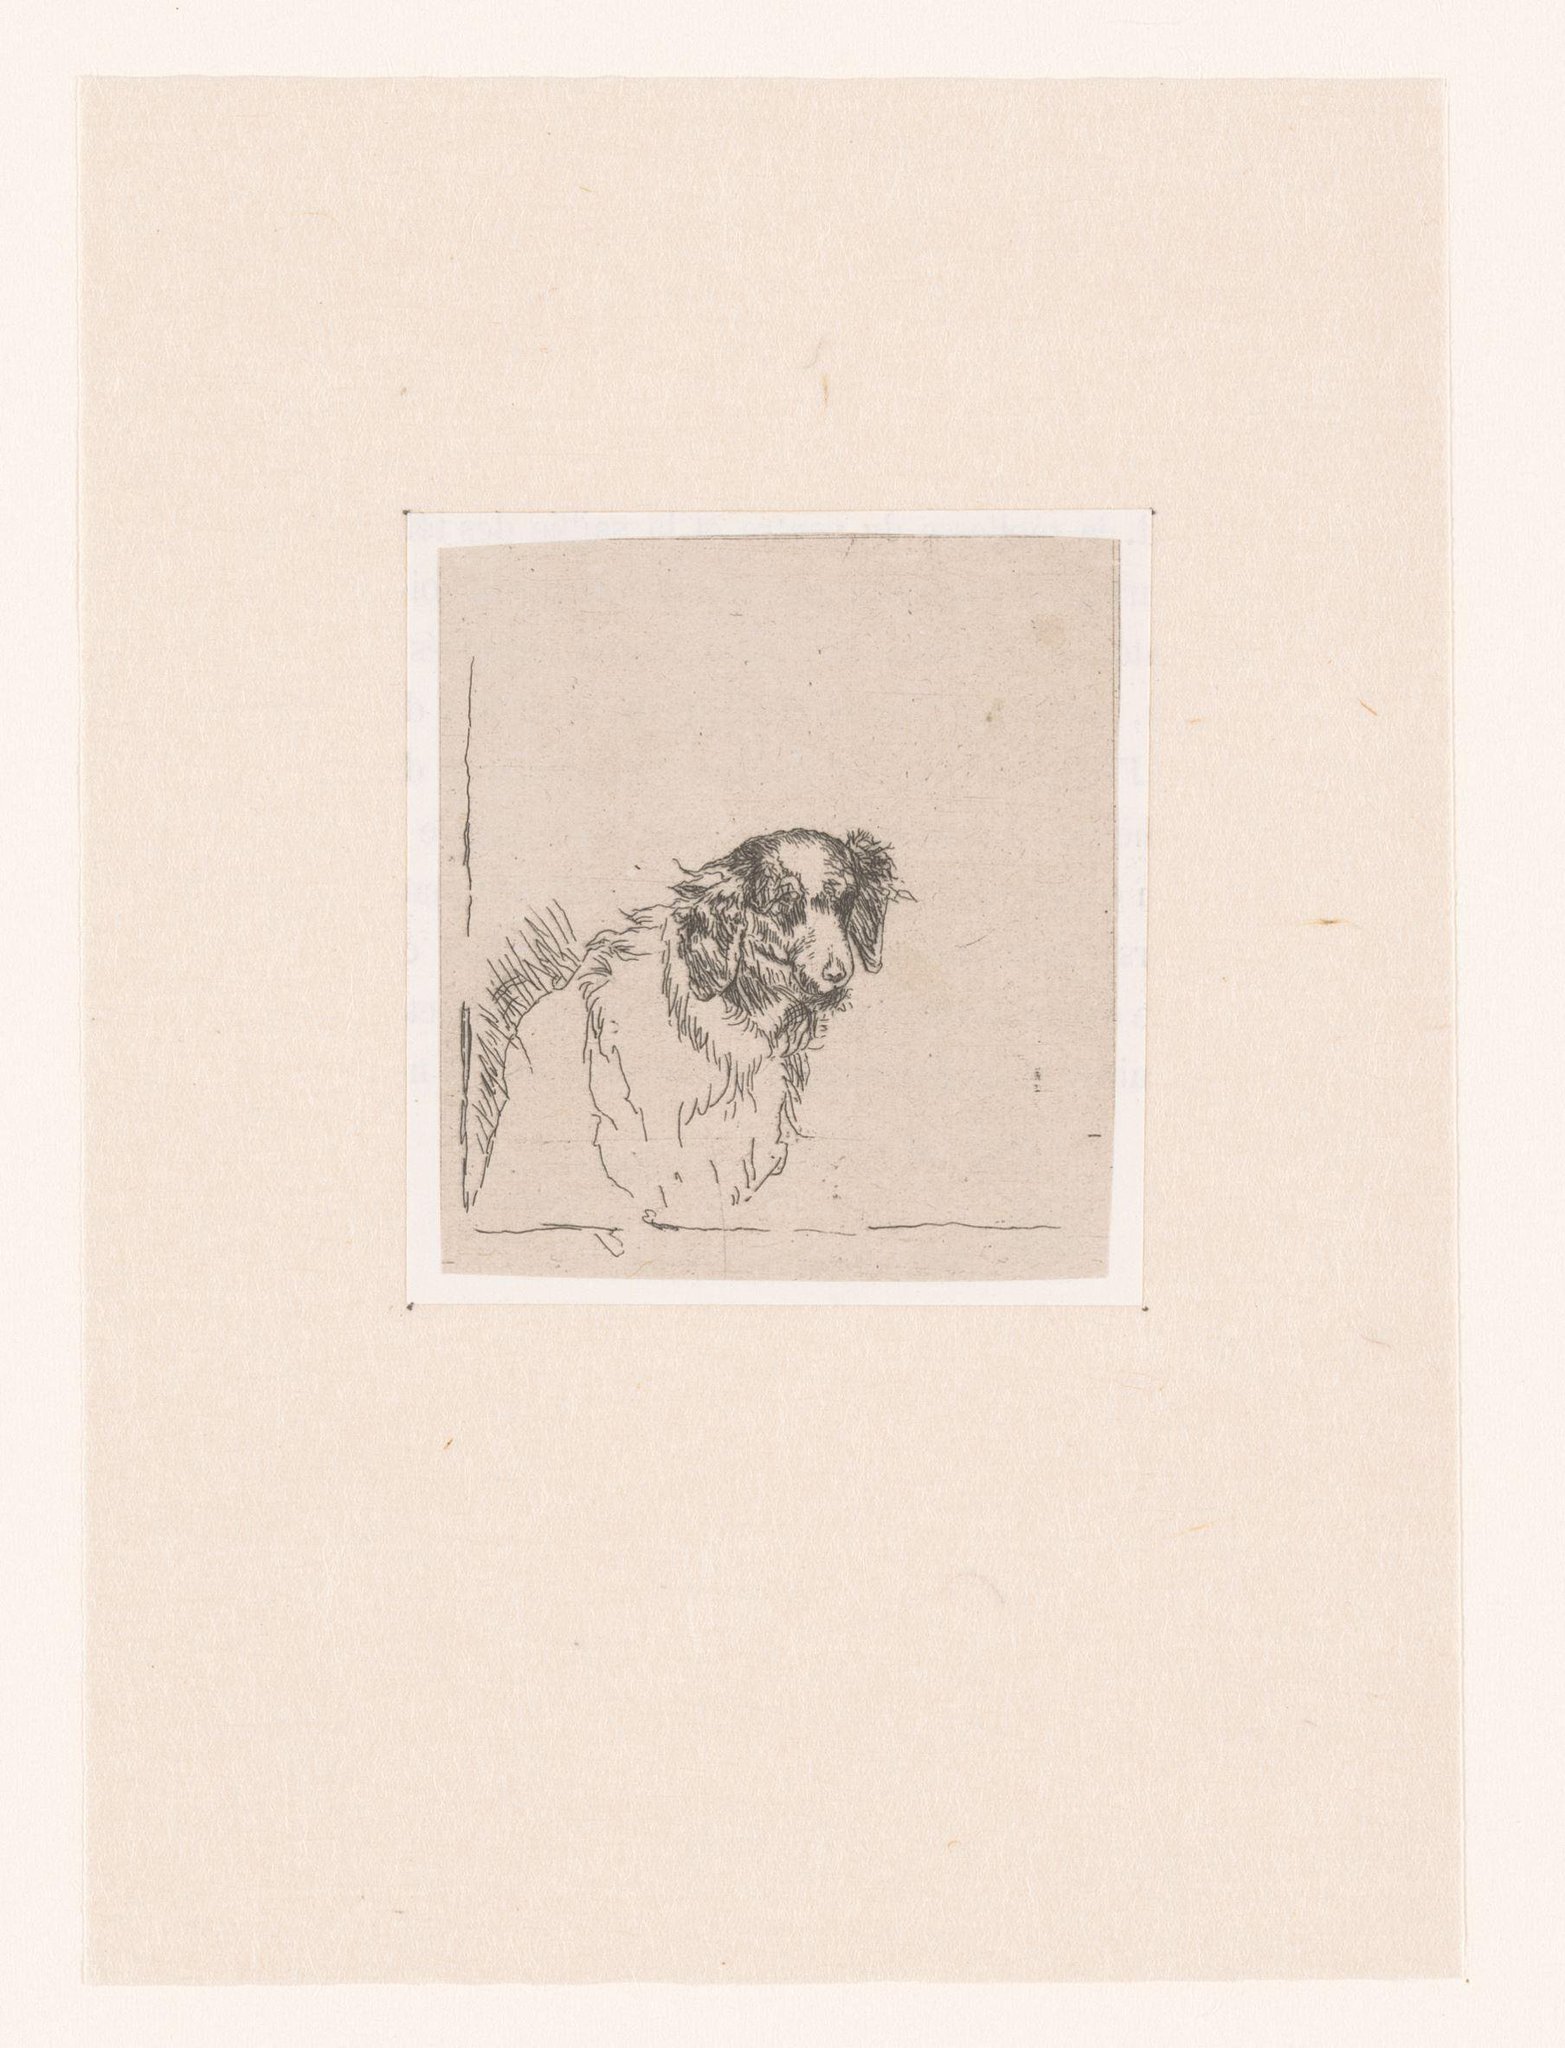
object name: print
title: Kop van een hond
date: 1859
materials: paper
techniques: etching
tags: dog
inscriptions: collector's mark: Lugt 2228, collector's mark: Lugt 2760